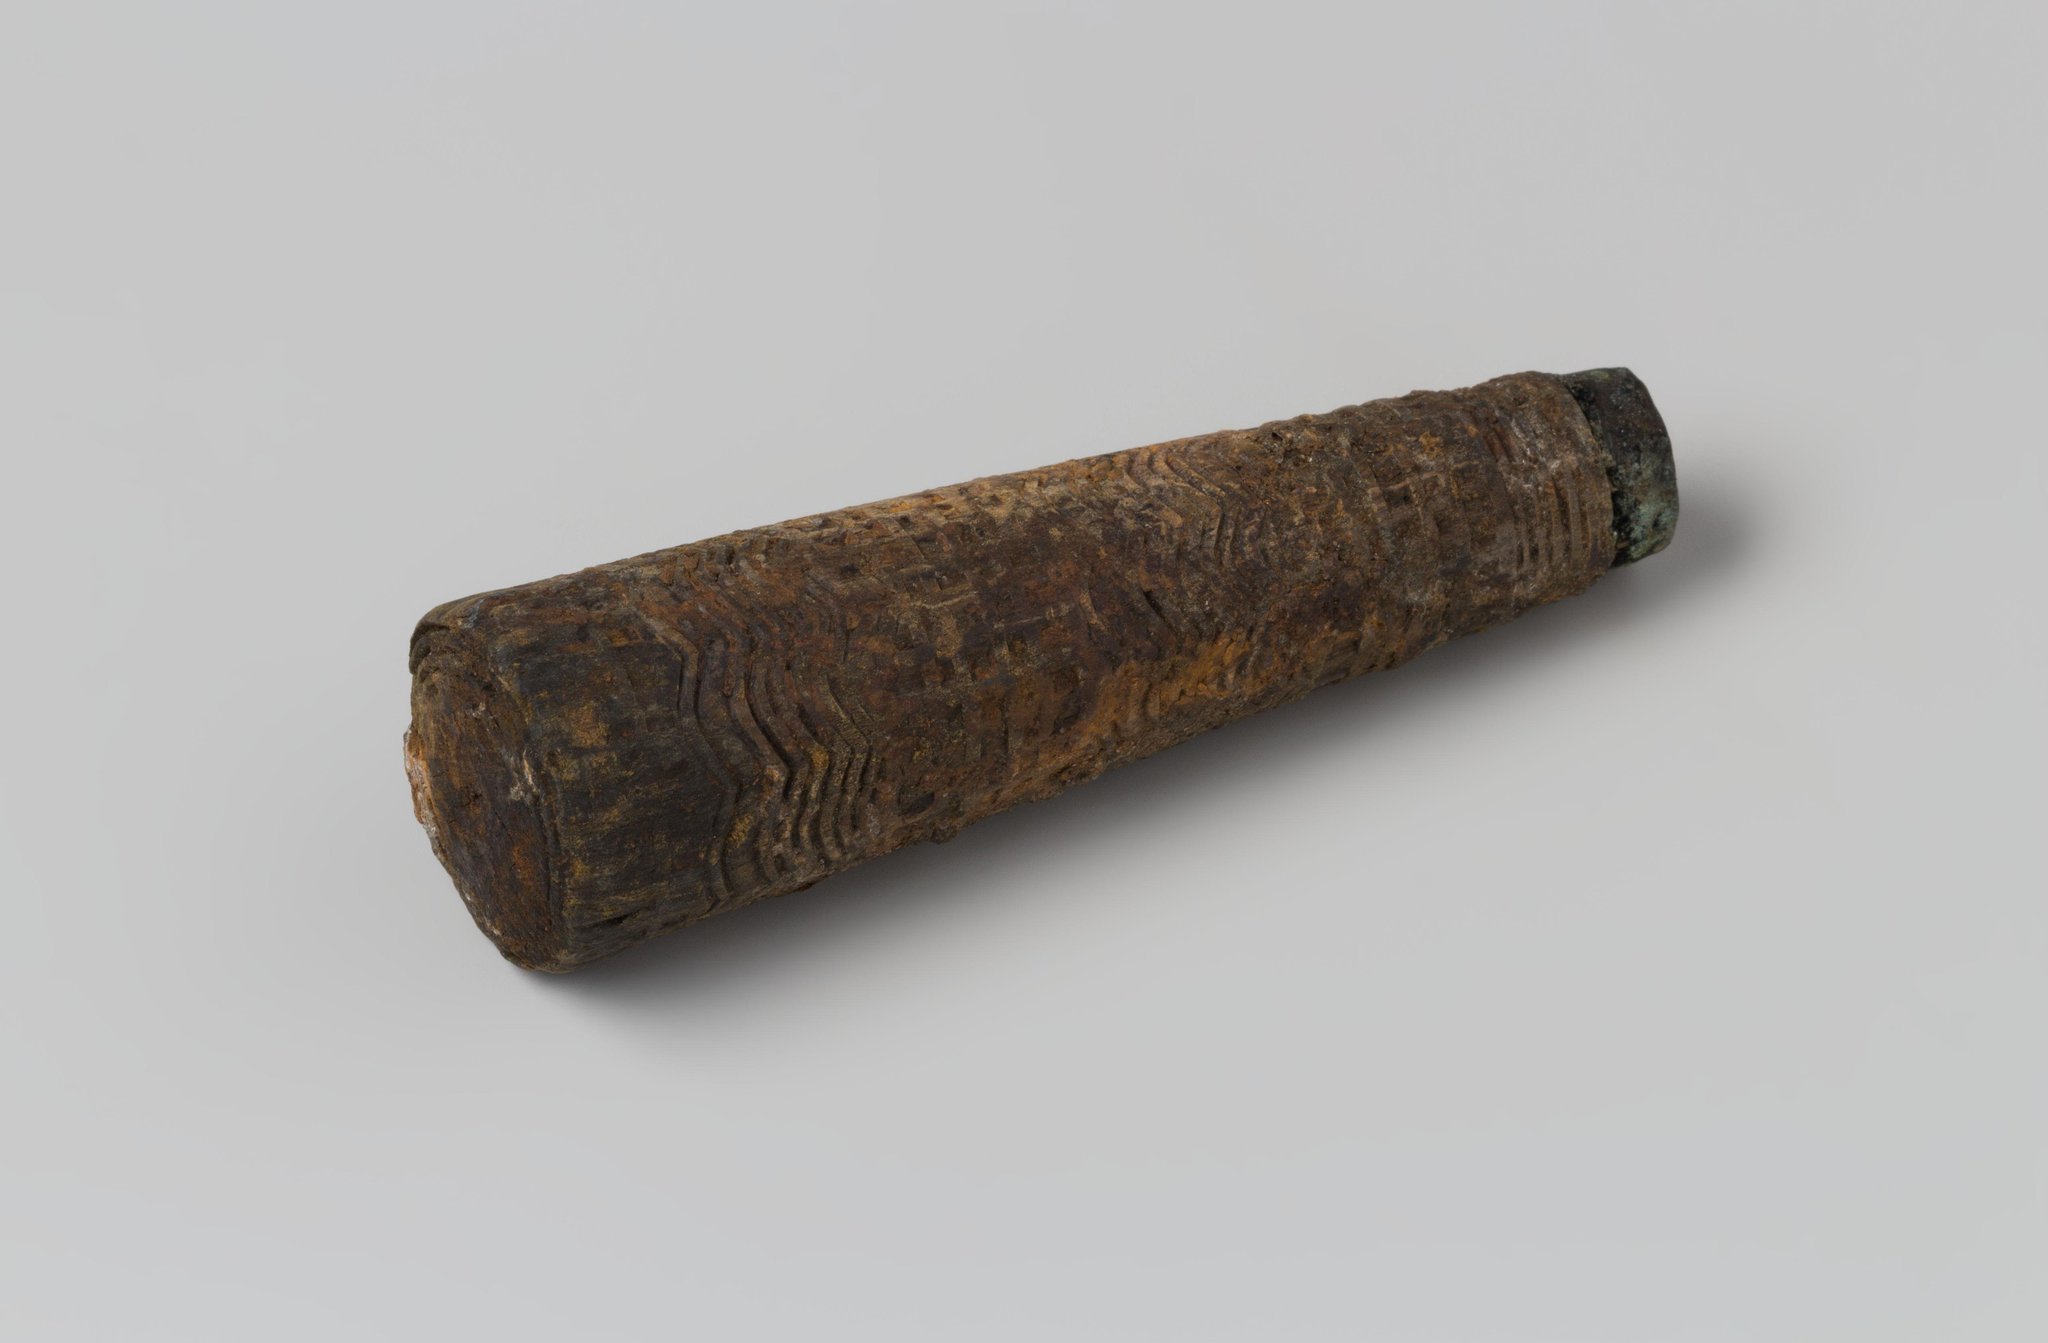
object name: knife handle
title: Messenheft uit het wrak van de Oost-Indiëvaarder Hollandia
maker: Anonymous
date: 1700-1743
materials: copper, wood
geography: netherlands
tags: verenigde oostindische compagnie, hollandia (schip), annet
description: Knife, handle, cylindrical: tapering; id. NG 1979-403H, ferrule, id. NG 1980-27H426.